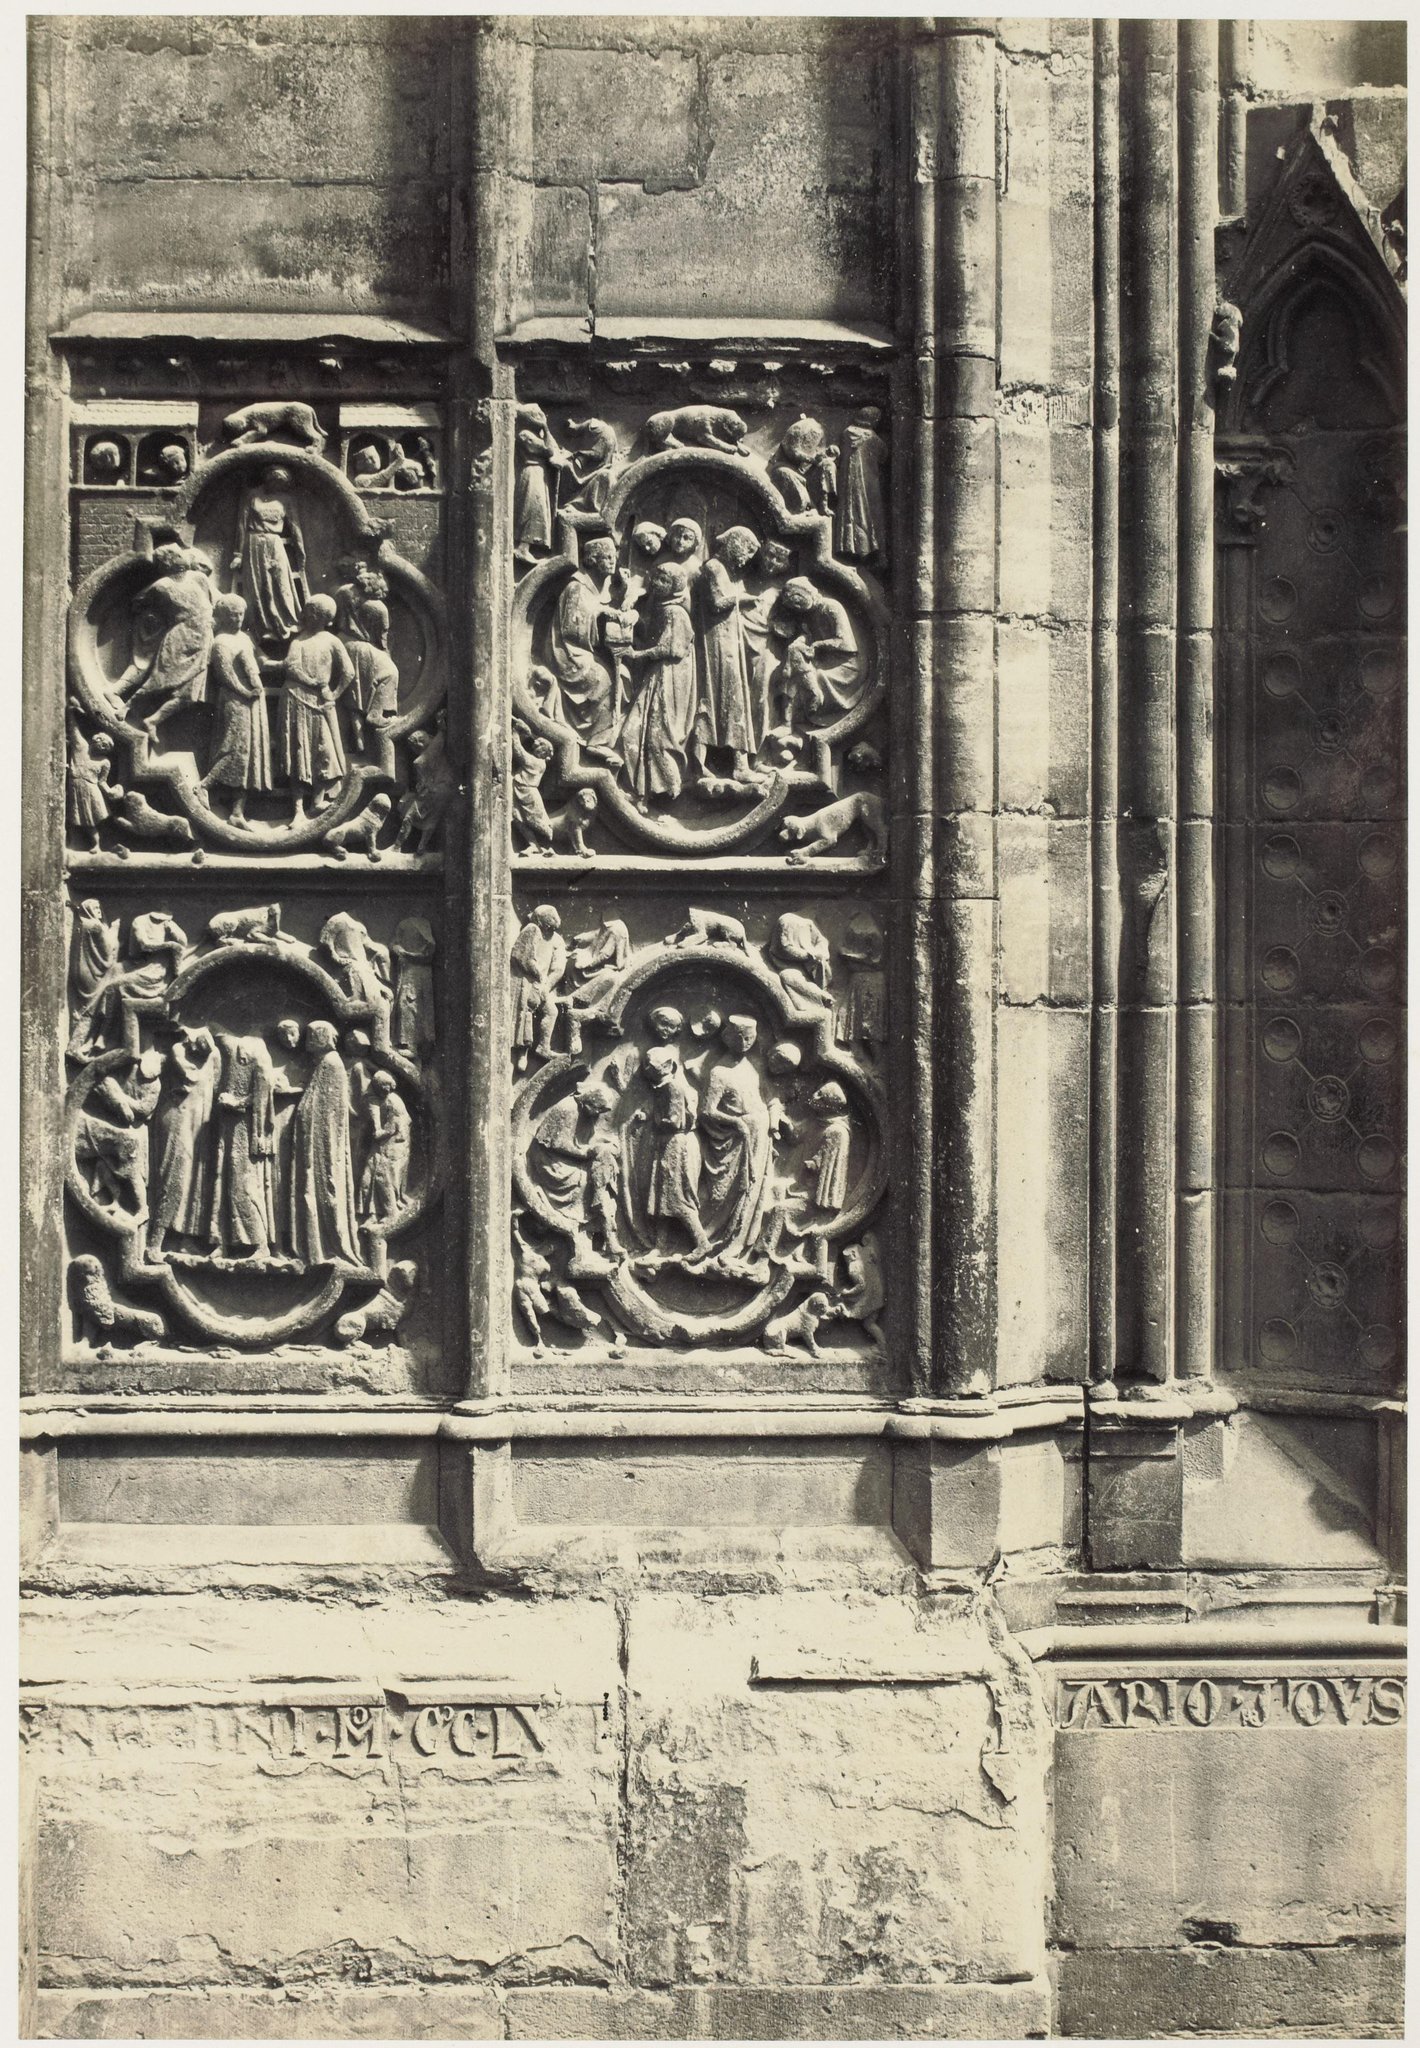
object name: photograph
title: Fragment du portail méridional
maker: a. morel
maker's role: publisher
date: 1853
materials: cardboard, paper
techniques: albumen print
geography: paris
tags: piece of sculpture, reproduction of a piece of sculpture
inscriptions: stamp: ‘Bibliotheek/ Rijksmuseum/ Amsterdam’